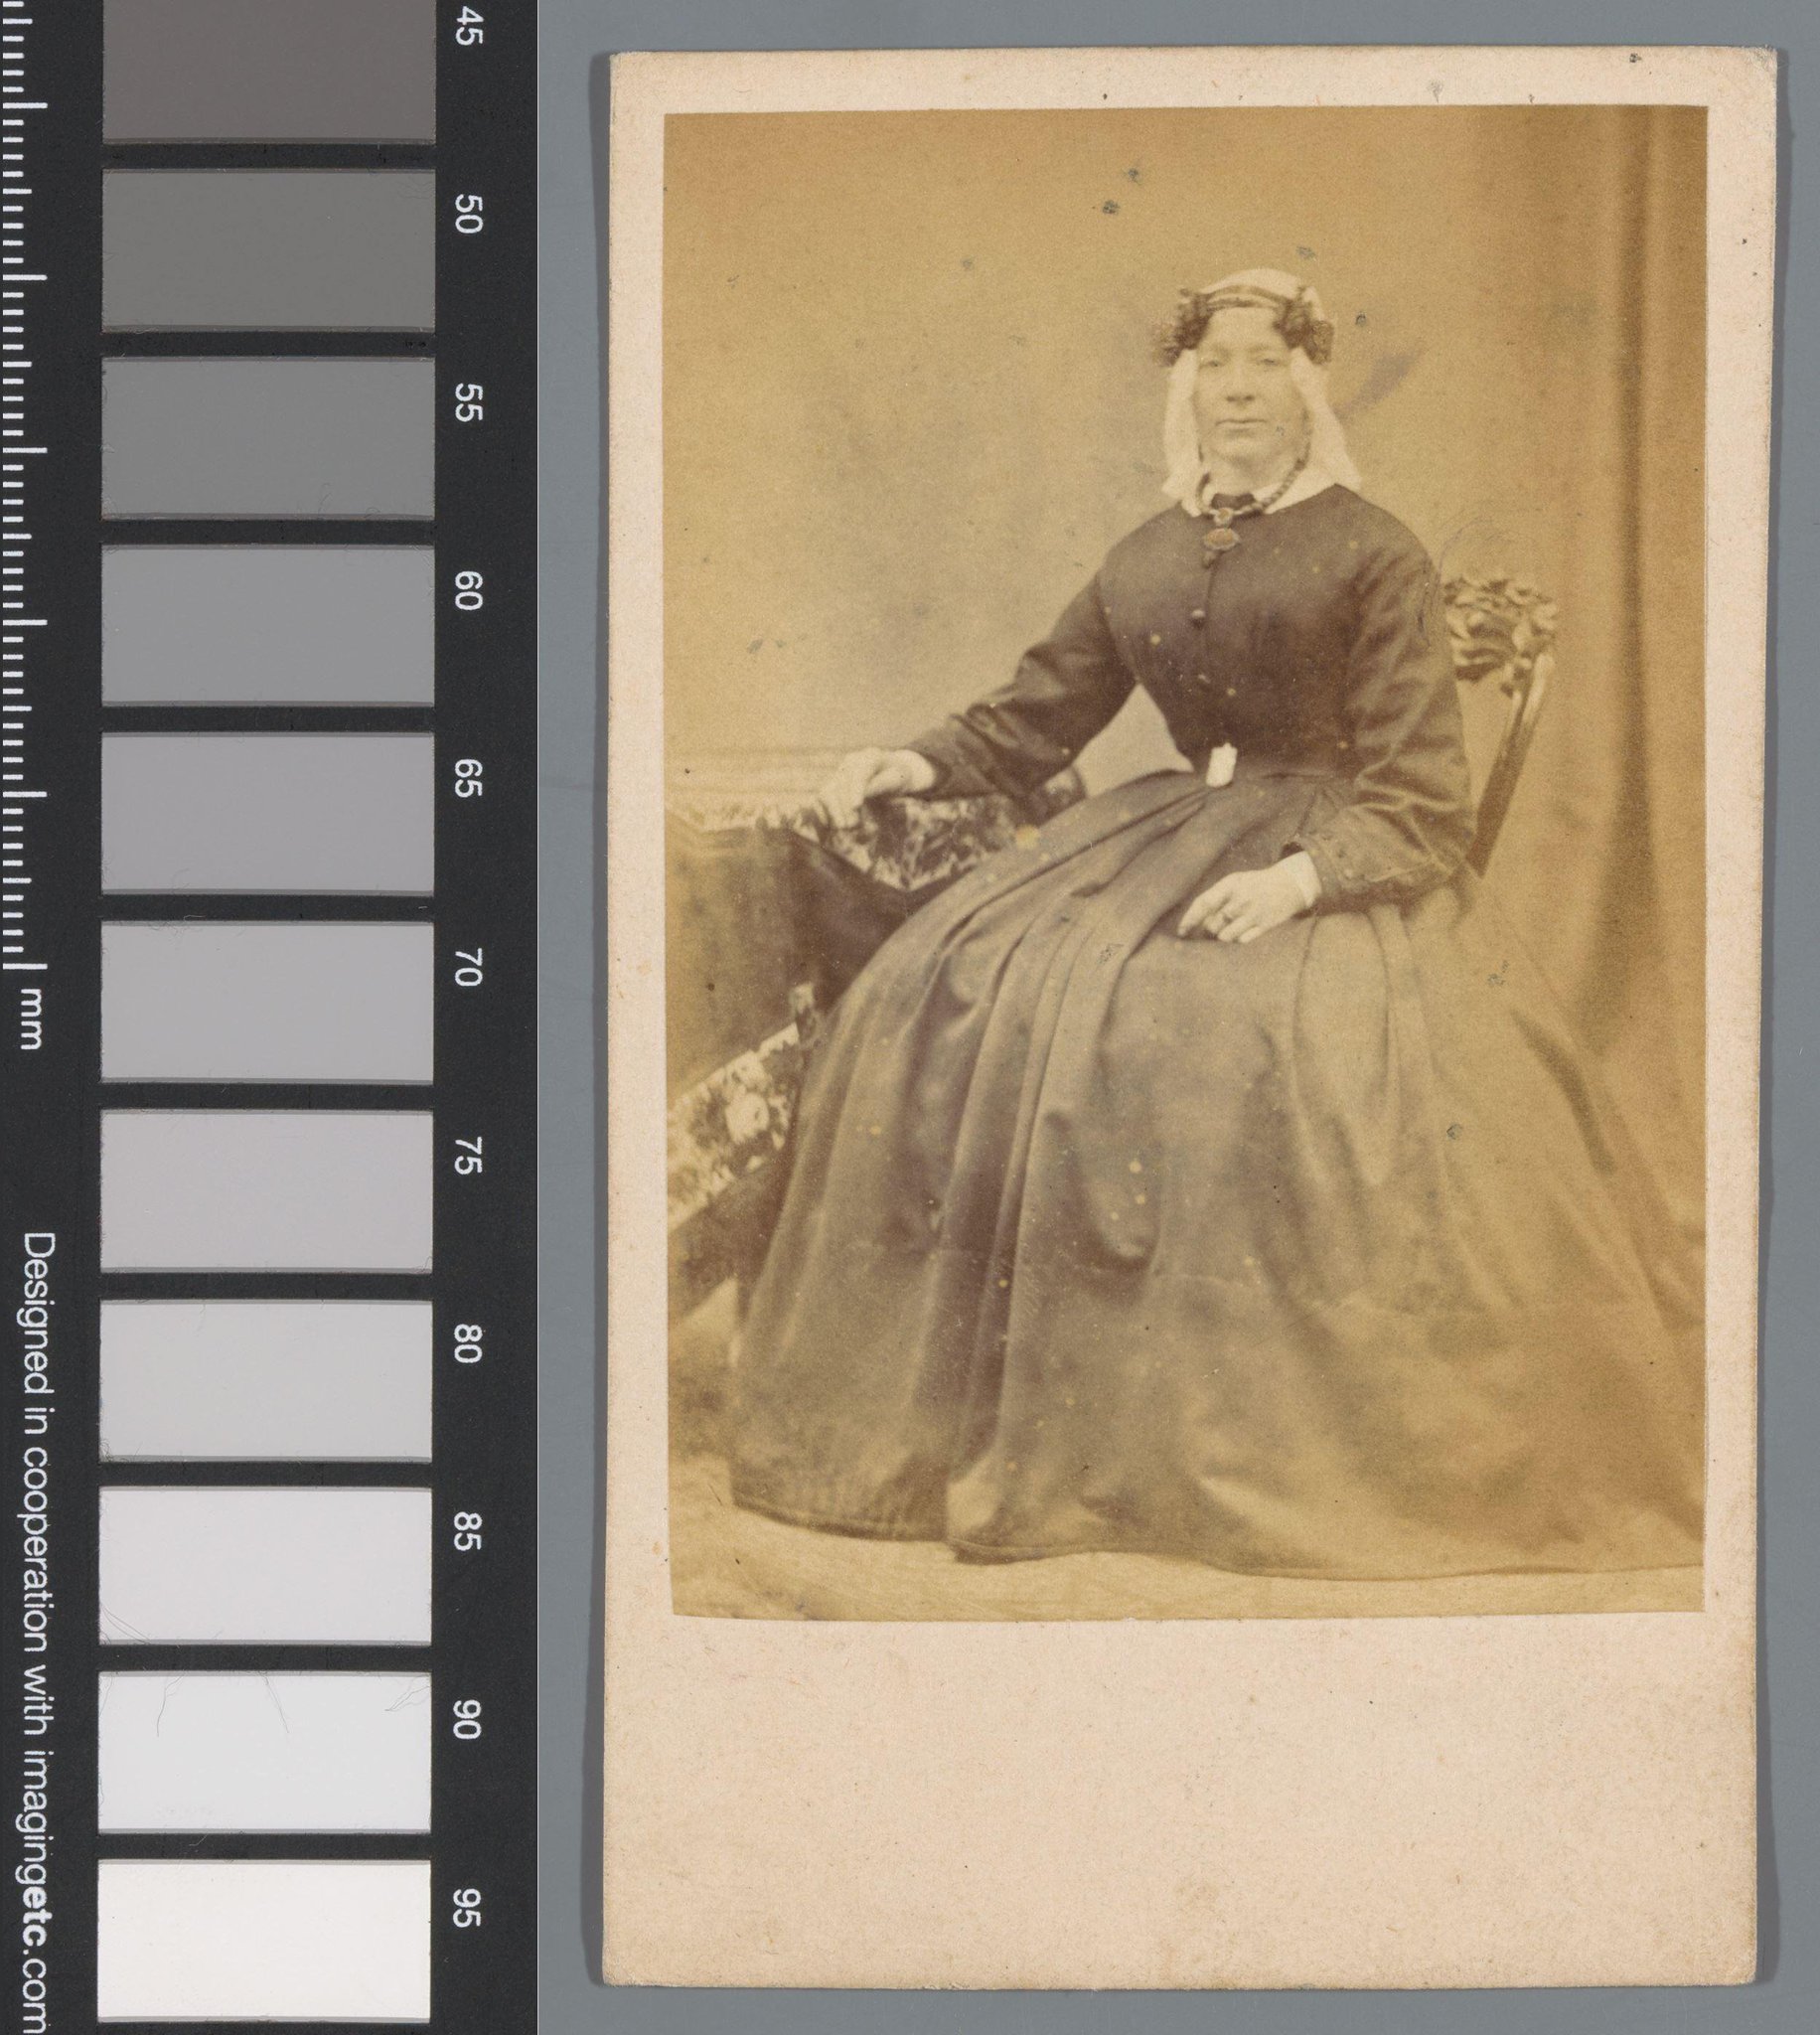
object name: photograph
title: Portret van een onbekende vrouw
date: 1868-1870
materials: cardboard, paper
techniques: albumen print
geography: amsterdam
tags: sitting figure, historical persons - bb - woman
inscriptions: inscription: ‘Photographisch Etablissement/ VAN/ C. Stapert & van Caspel./ Bloemgracht D.D. 43./ AMSTERDAM.’